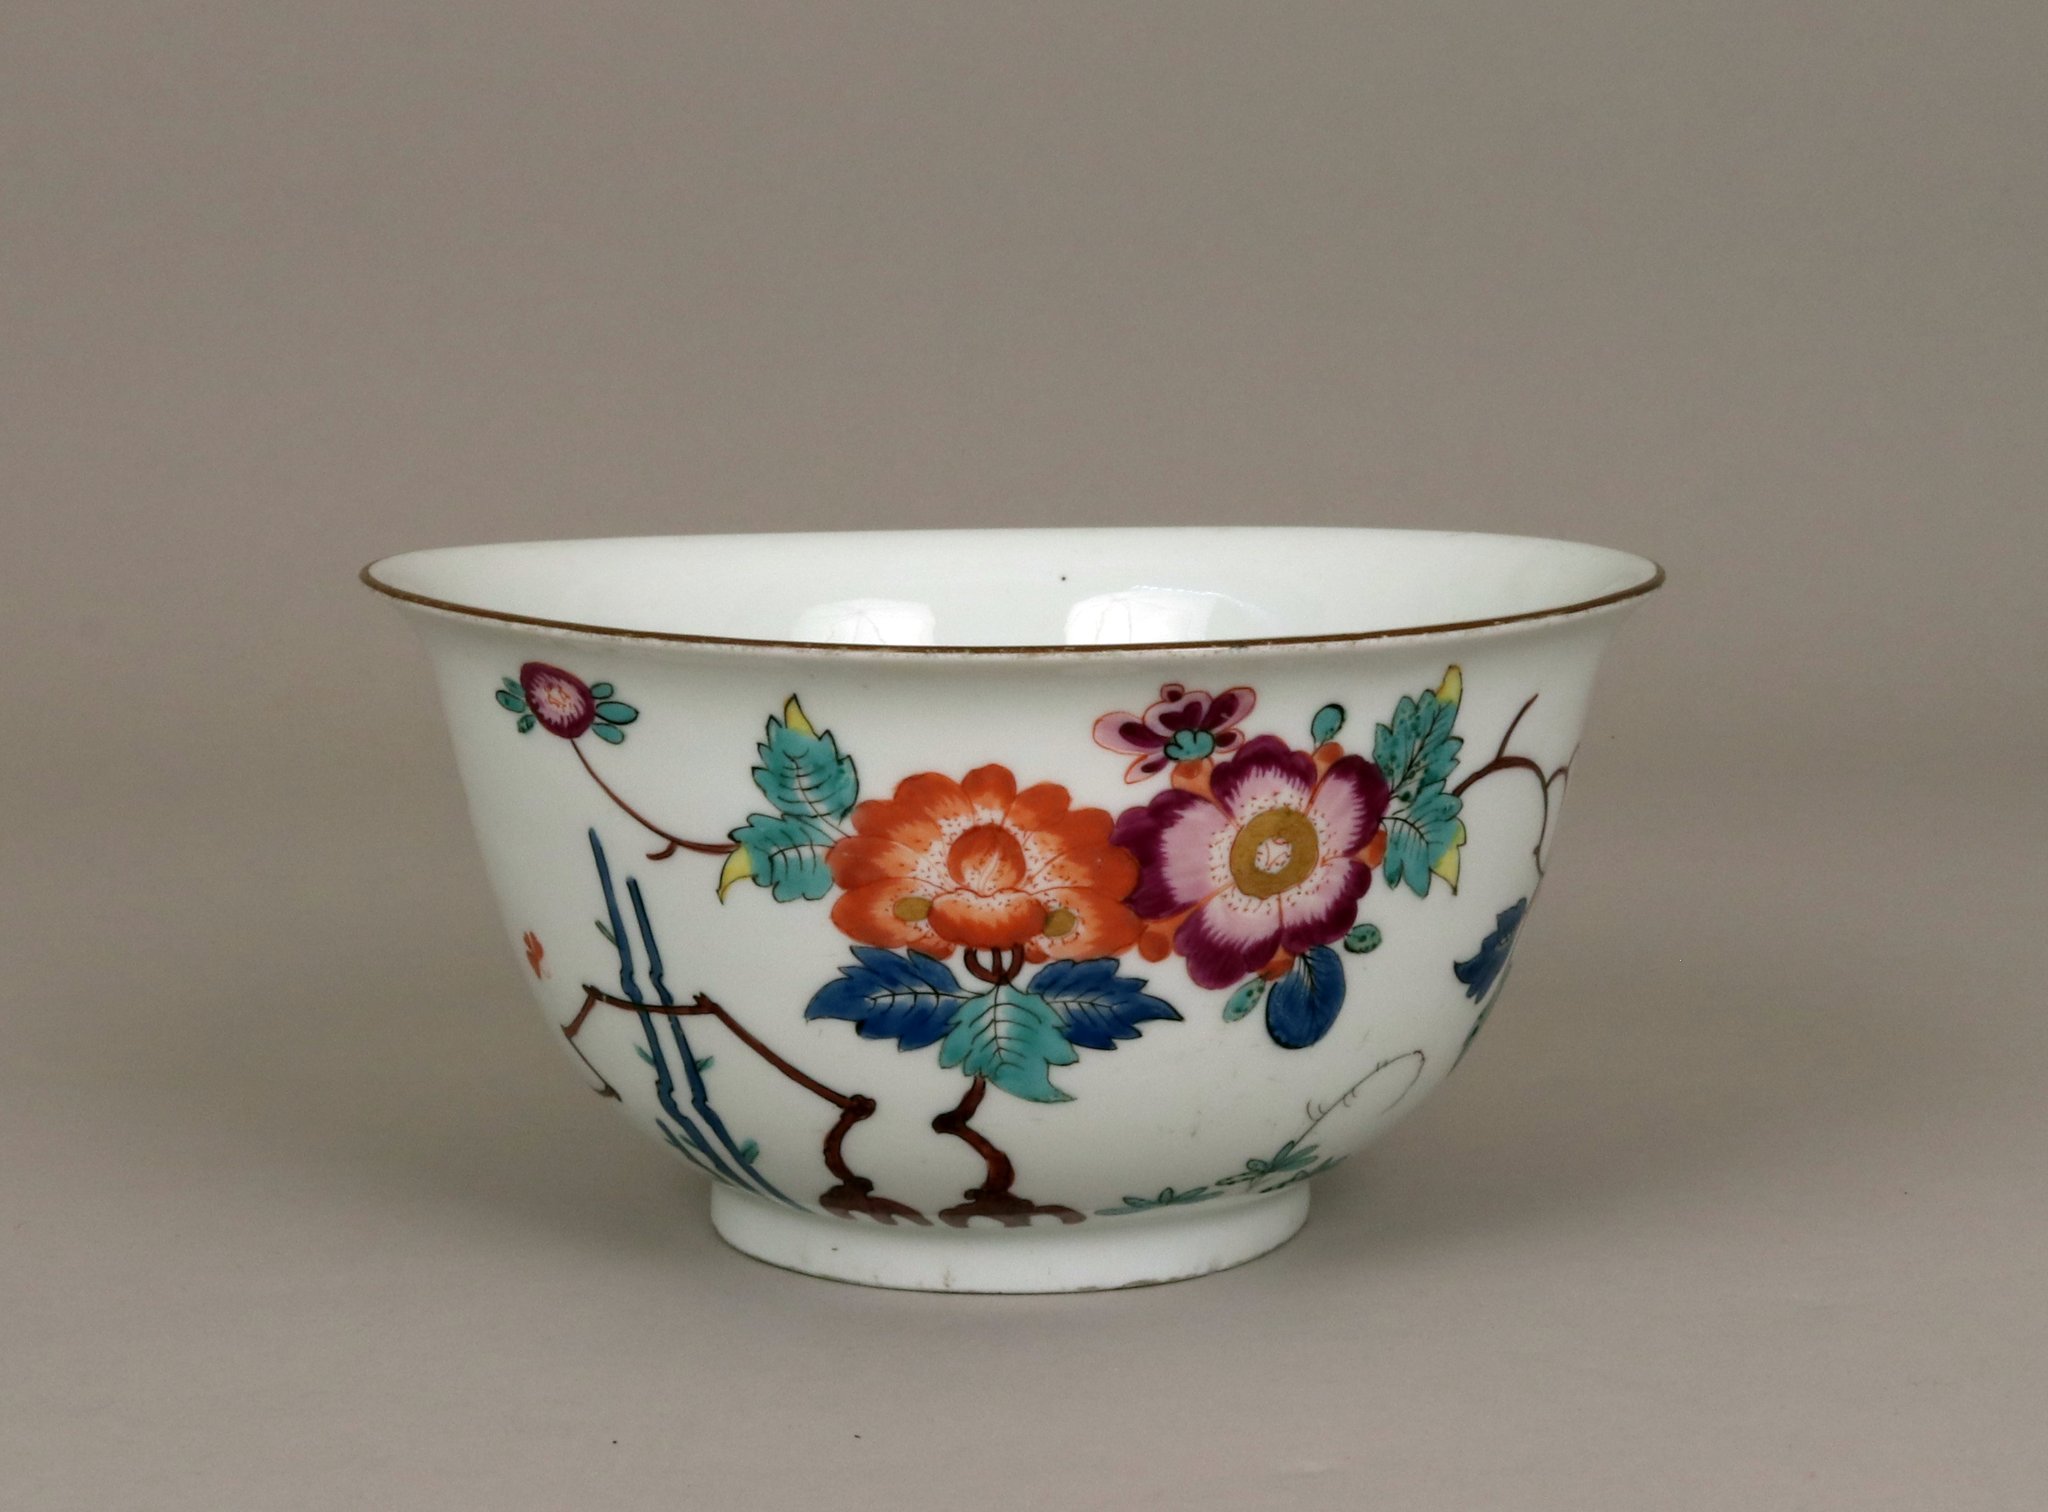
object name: bowl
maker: meissen manufactory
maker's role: manufactory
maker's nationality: german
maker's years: 1710-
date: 1740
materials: hard paste porcelain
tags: flowers